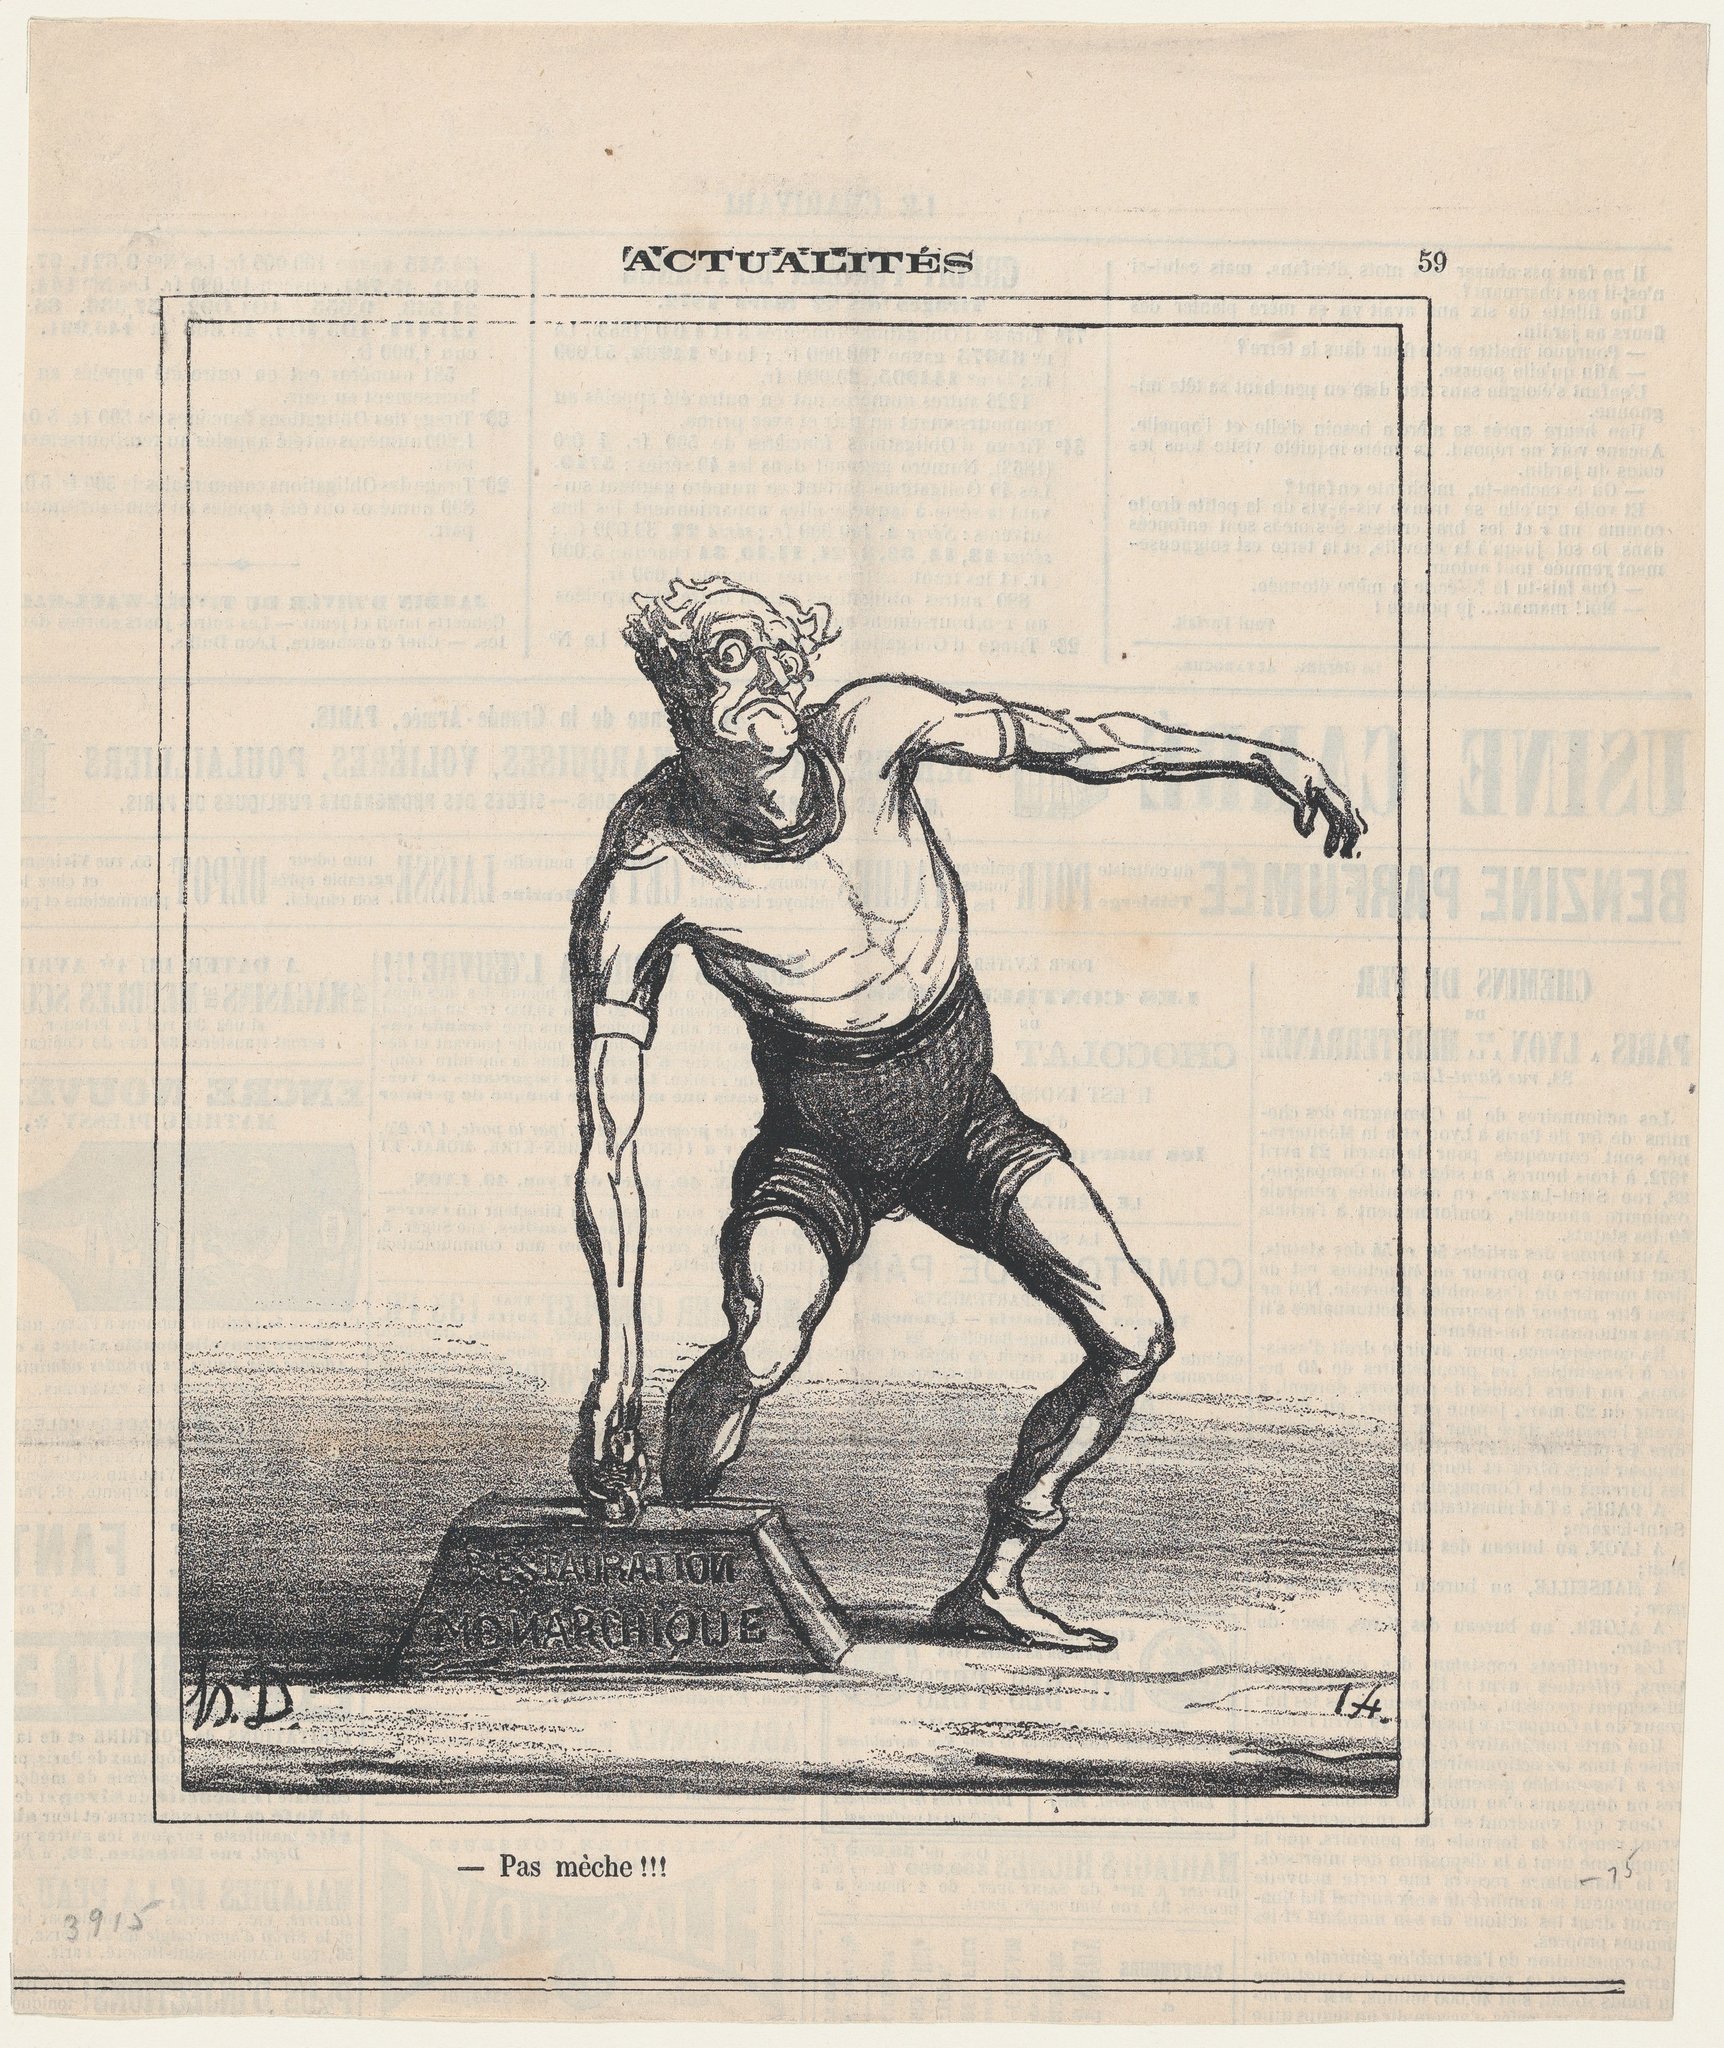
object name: print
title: It's quite impossible!!!, from 'News of the day,' published in Le Charivari, March 28, 1872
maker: honoré daumier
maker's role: artist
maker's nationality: french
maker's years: 1808-1879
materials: paper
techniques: lithograph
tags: men